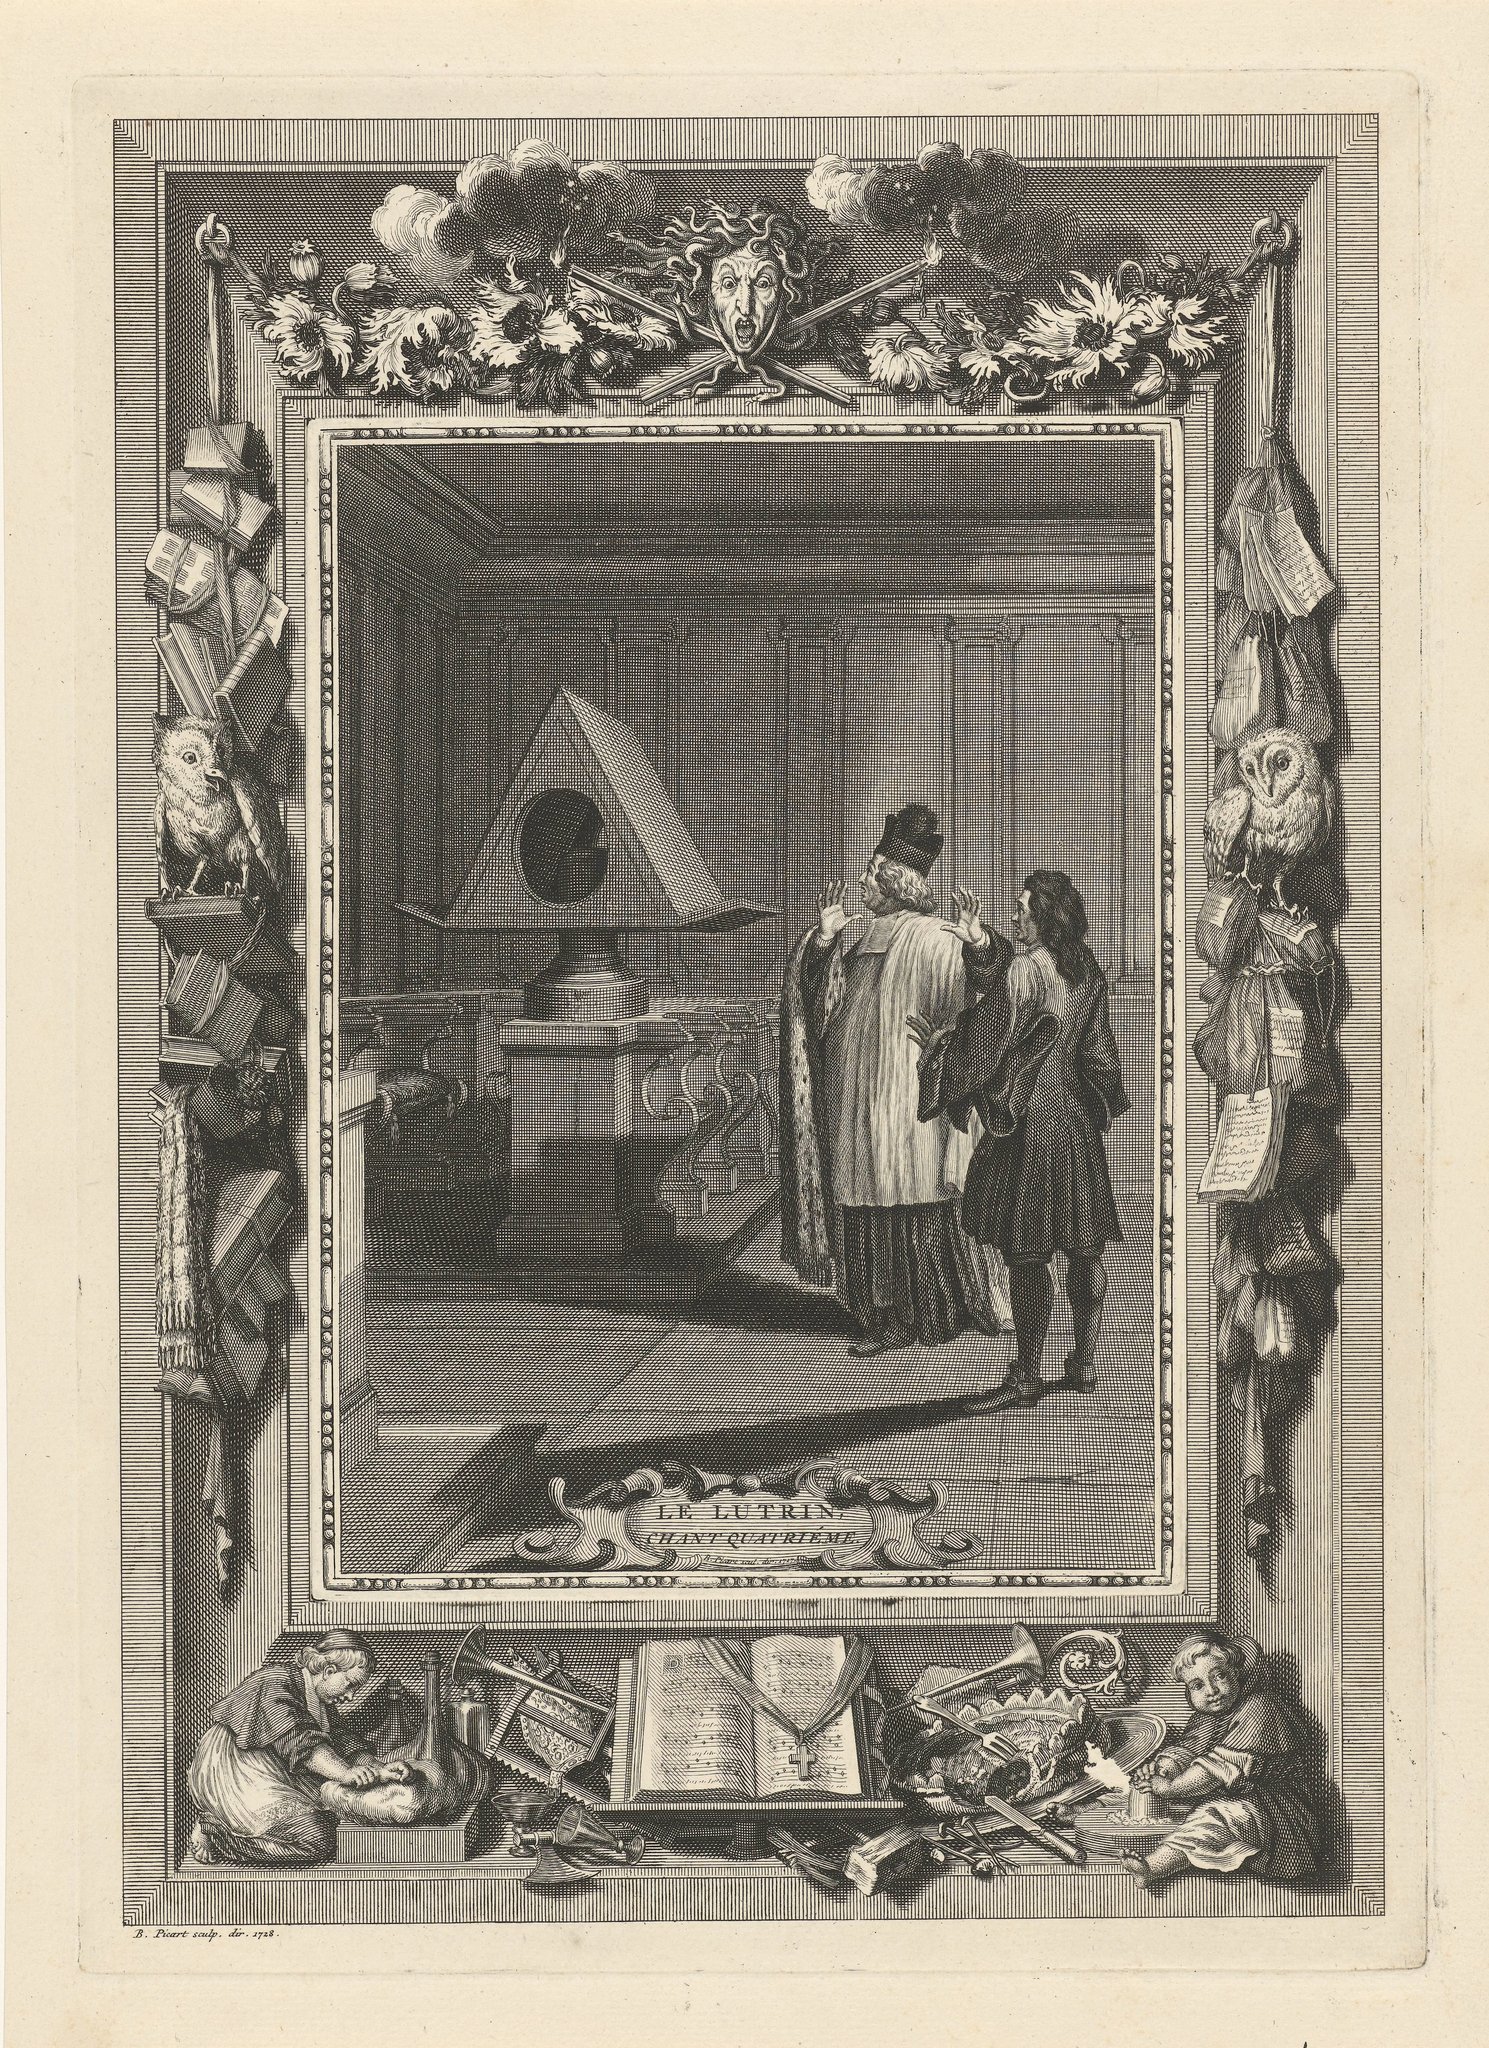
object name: print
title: Le Lutrin. Chant Quatriéme.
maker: bernard picart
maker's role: draughtsman, print maker, publisher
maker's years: 1673-1733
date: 1717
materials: paper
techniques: engraving, etching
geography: amsterdam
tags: lectern, insignia of bishop, e.g. mitre, crozier, hierarchy of jurisdiction ~ roman catholic church, gorgoneion, head of medusa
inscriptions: collector's mark: Lugt 2228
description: De priester, zijn handen opgeheven, kijkt verbaasd en geschrokken naar de lessenaar in de kerk. Hij wordt vergezeld door een man die ook schrikt. De voorstelling is gedecoreerd met een ornamentele omlijsting die wordt bekroond door een Medusahoofd. Onderaan een opengeslagen liedboek en diverse attributen van een bisschop.